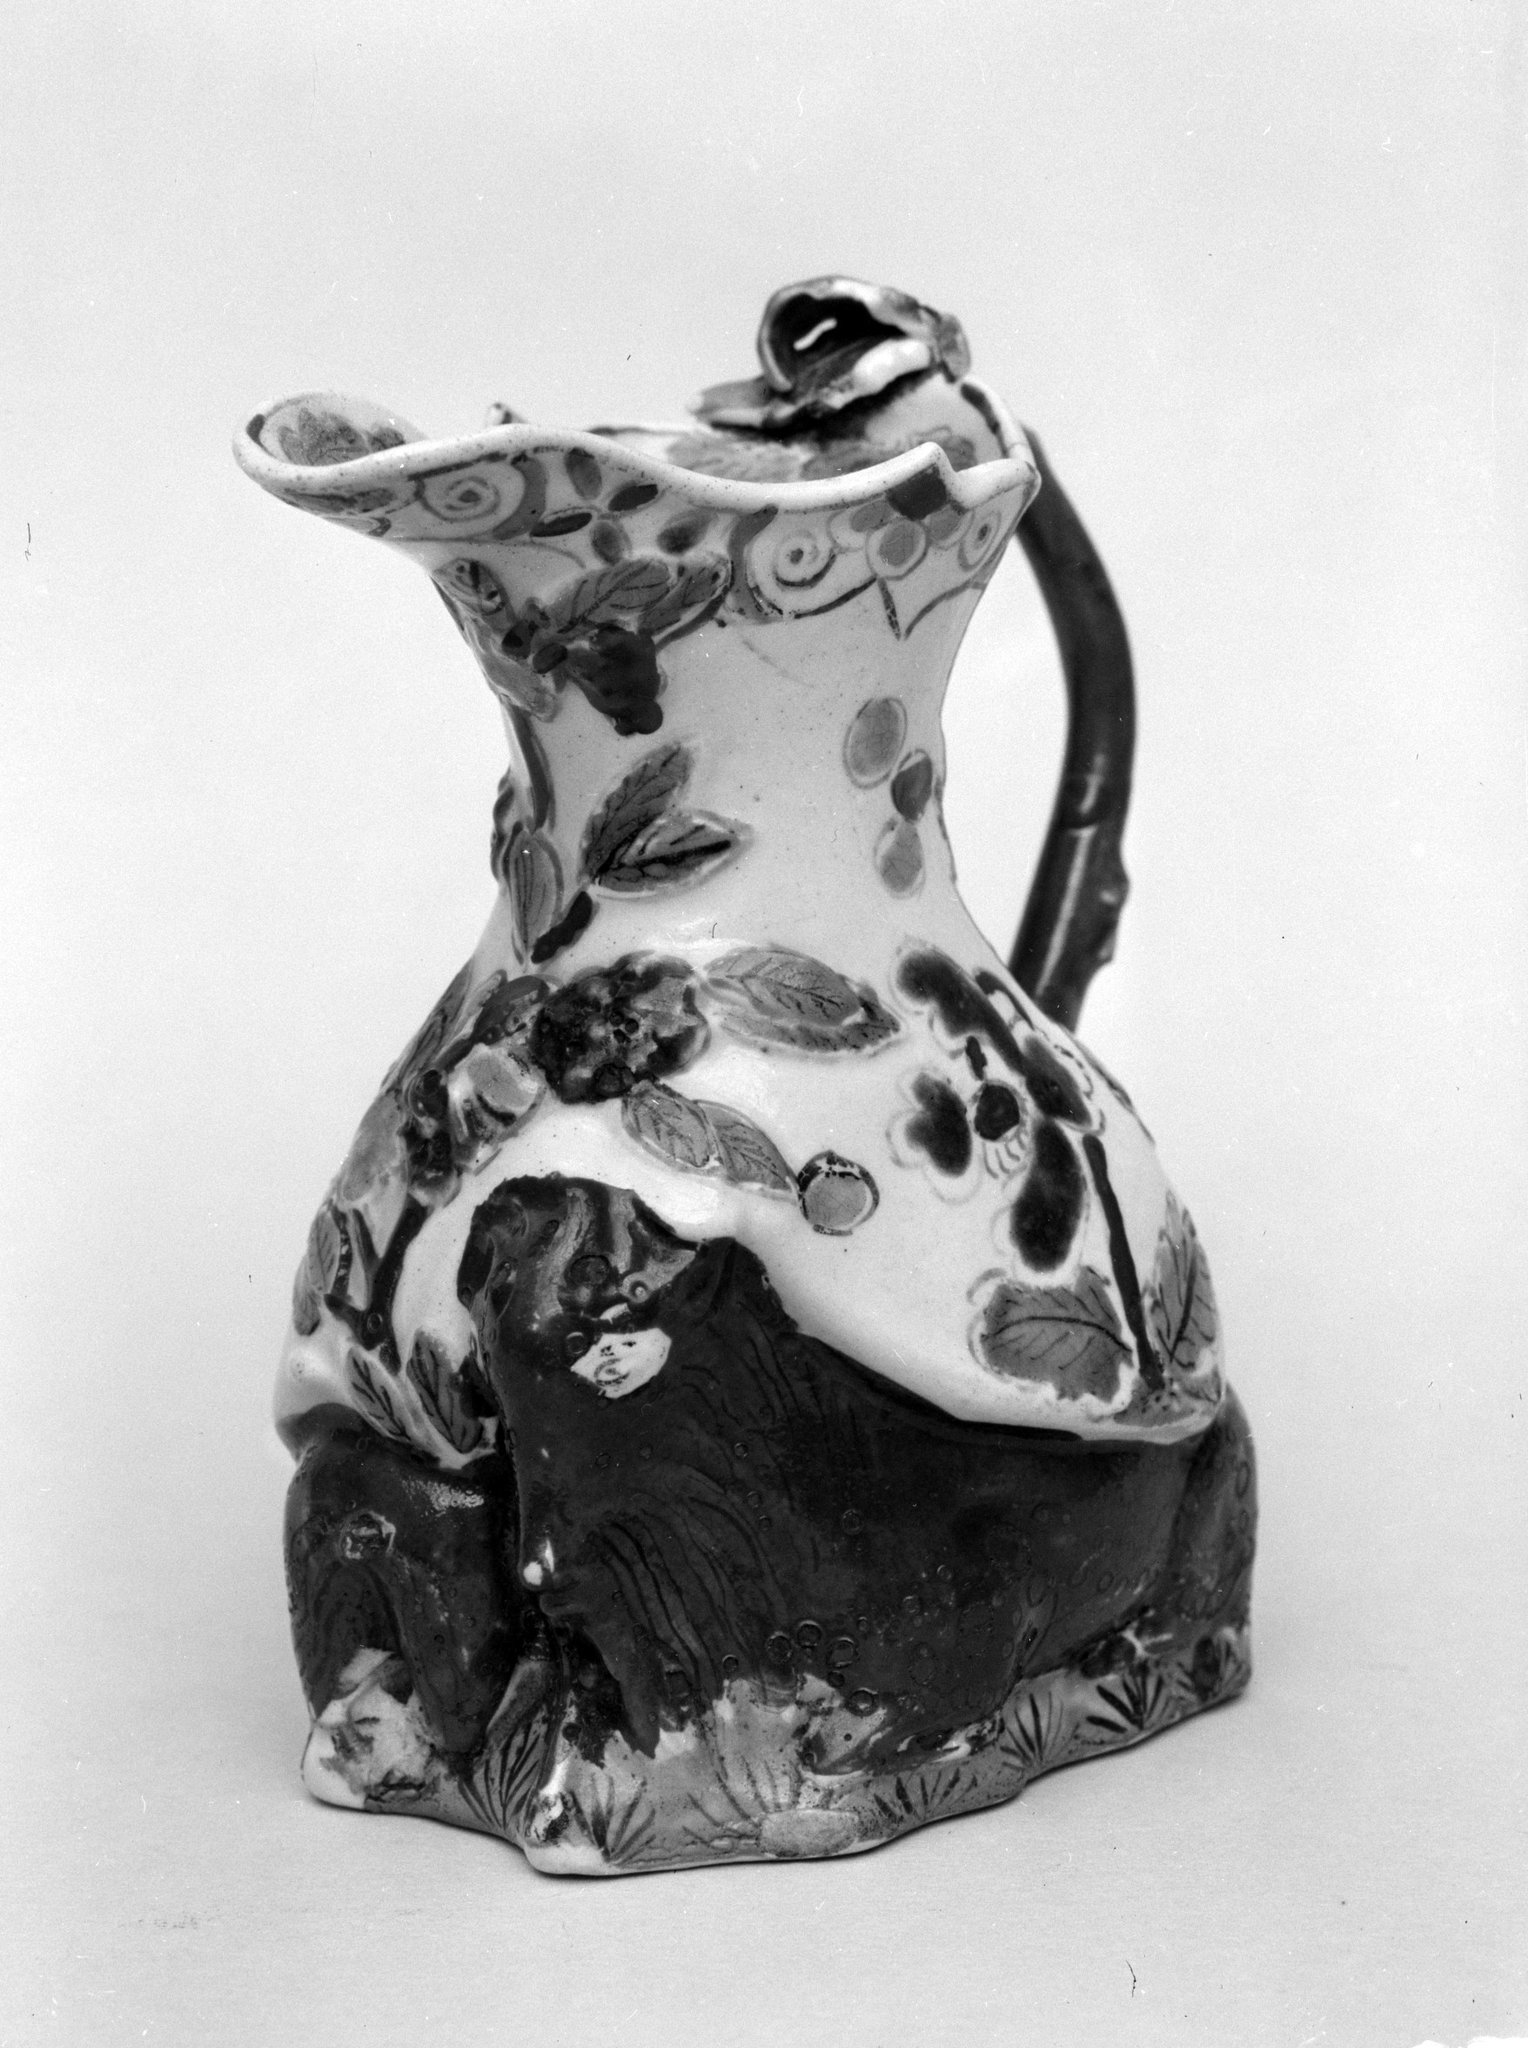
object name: cream pot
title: Creamer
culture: british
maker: chelsea factory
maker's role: maker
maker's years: 1742-1784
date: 1745-1750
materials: stoneware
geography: england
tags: flowers